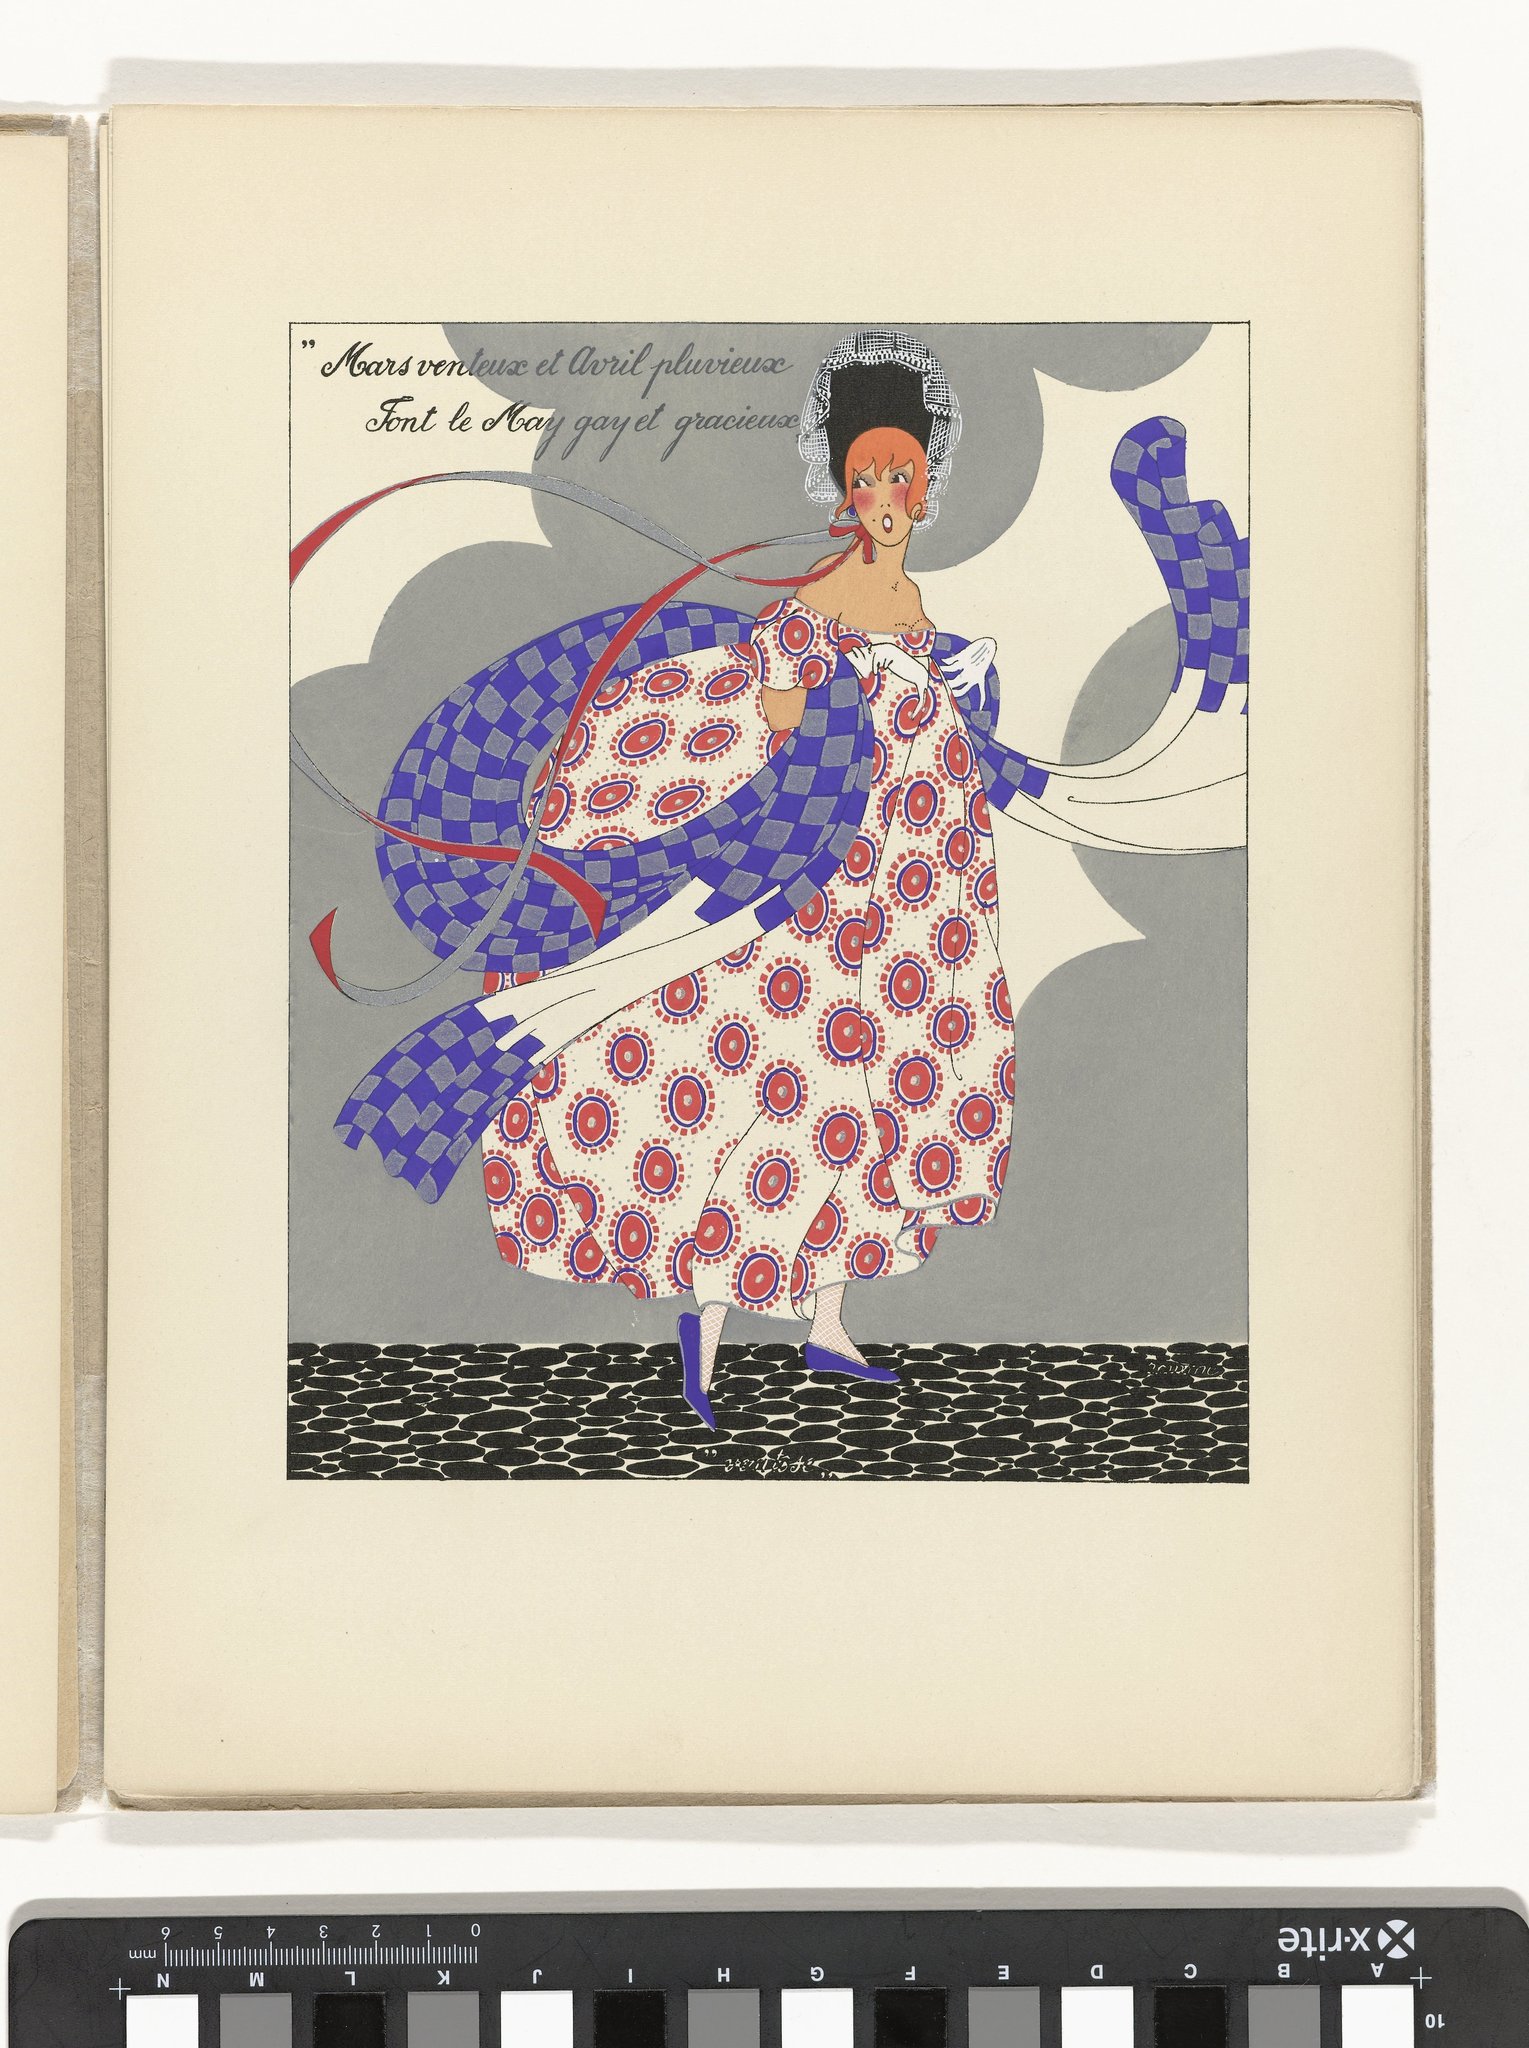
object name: fashion print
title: Les Douze Mois de l'Année: Ventose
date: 1919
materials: paper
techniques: pochoir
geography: paris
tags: fashion plates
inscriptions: inscription: ‘"Mars ventuex...’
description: Februari. Prent uit serie Les Douze Mois de l'Année.